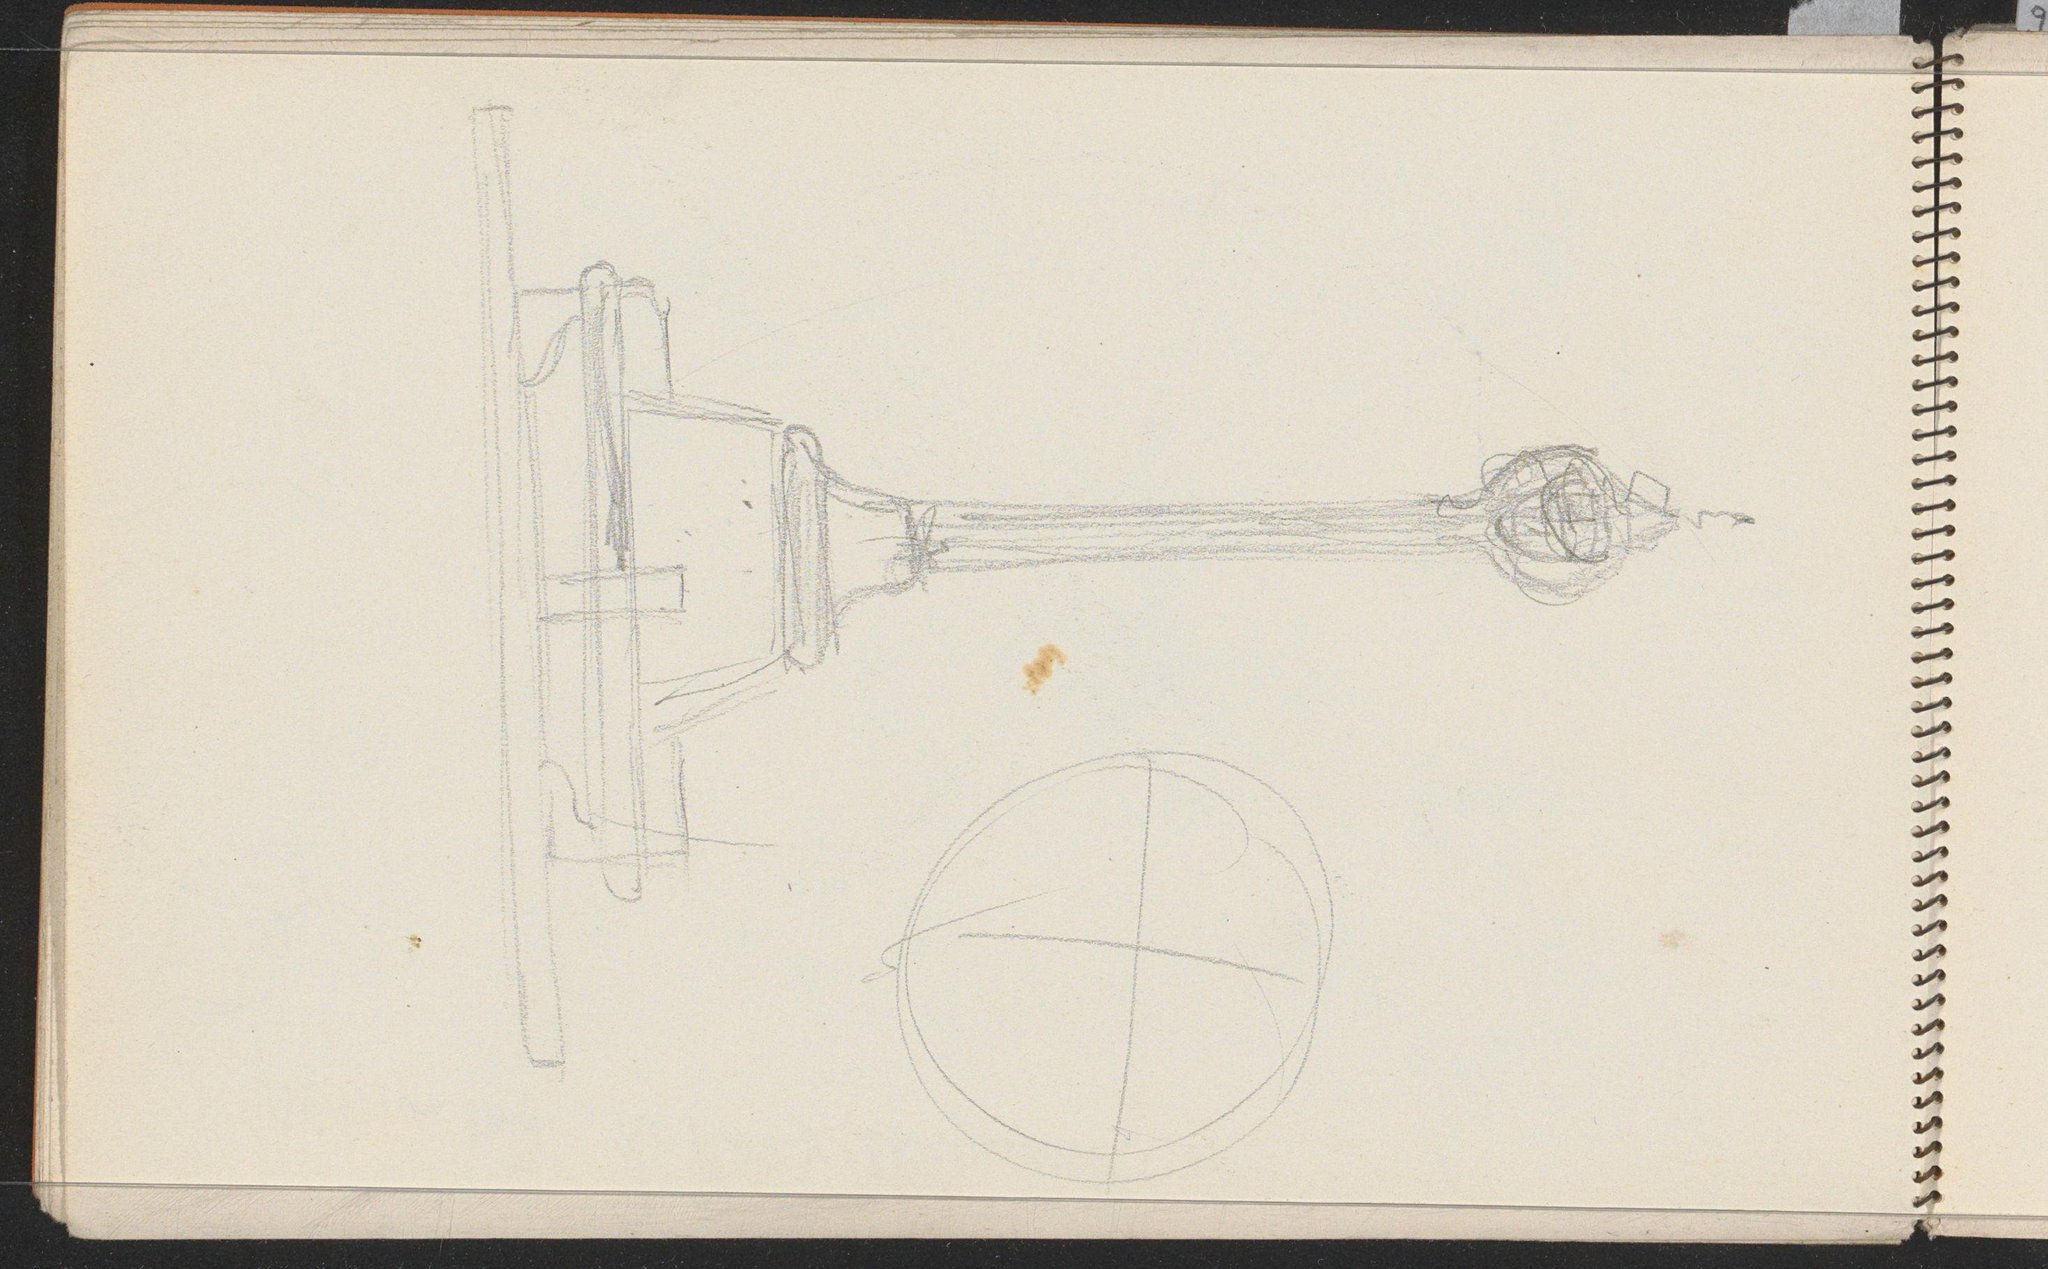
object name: sketchbook leaf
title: Zuil met een bol op een sokkel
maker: carel adolph lion cachet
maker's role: draughtsman, print maker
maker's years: 1864-1945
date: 1930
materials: paper, pencil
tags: monument, statue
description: Tevens een studie van een in vieren gedeelde cirkel. Blad 6 verso uit een schetsboek met 20 bladen.